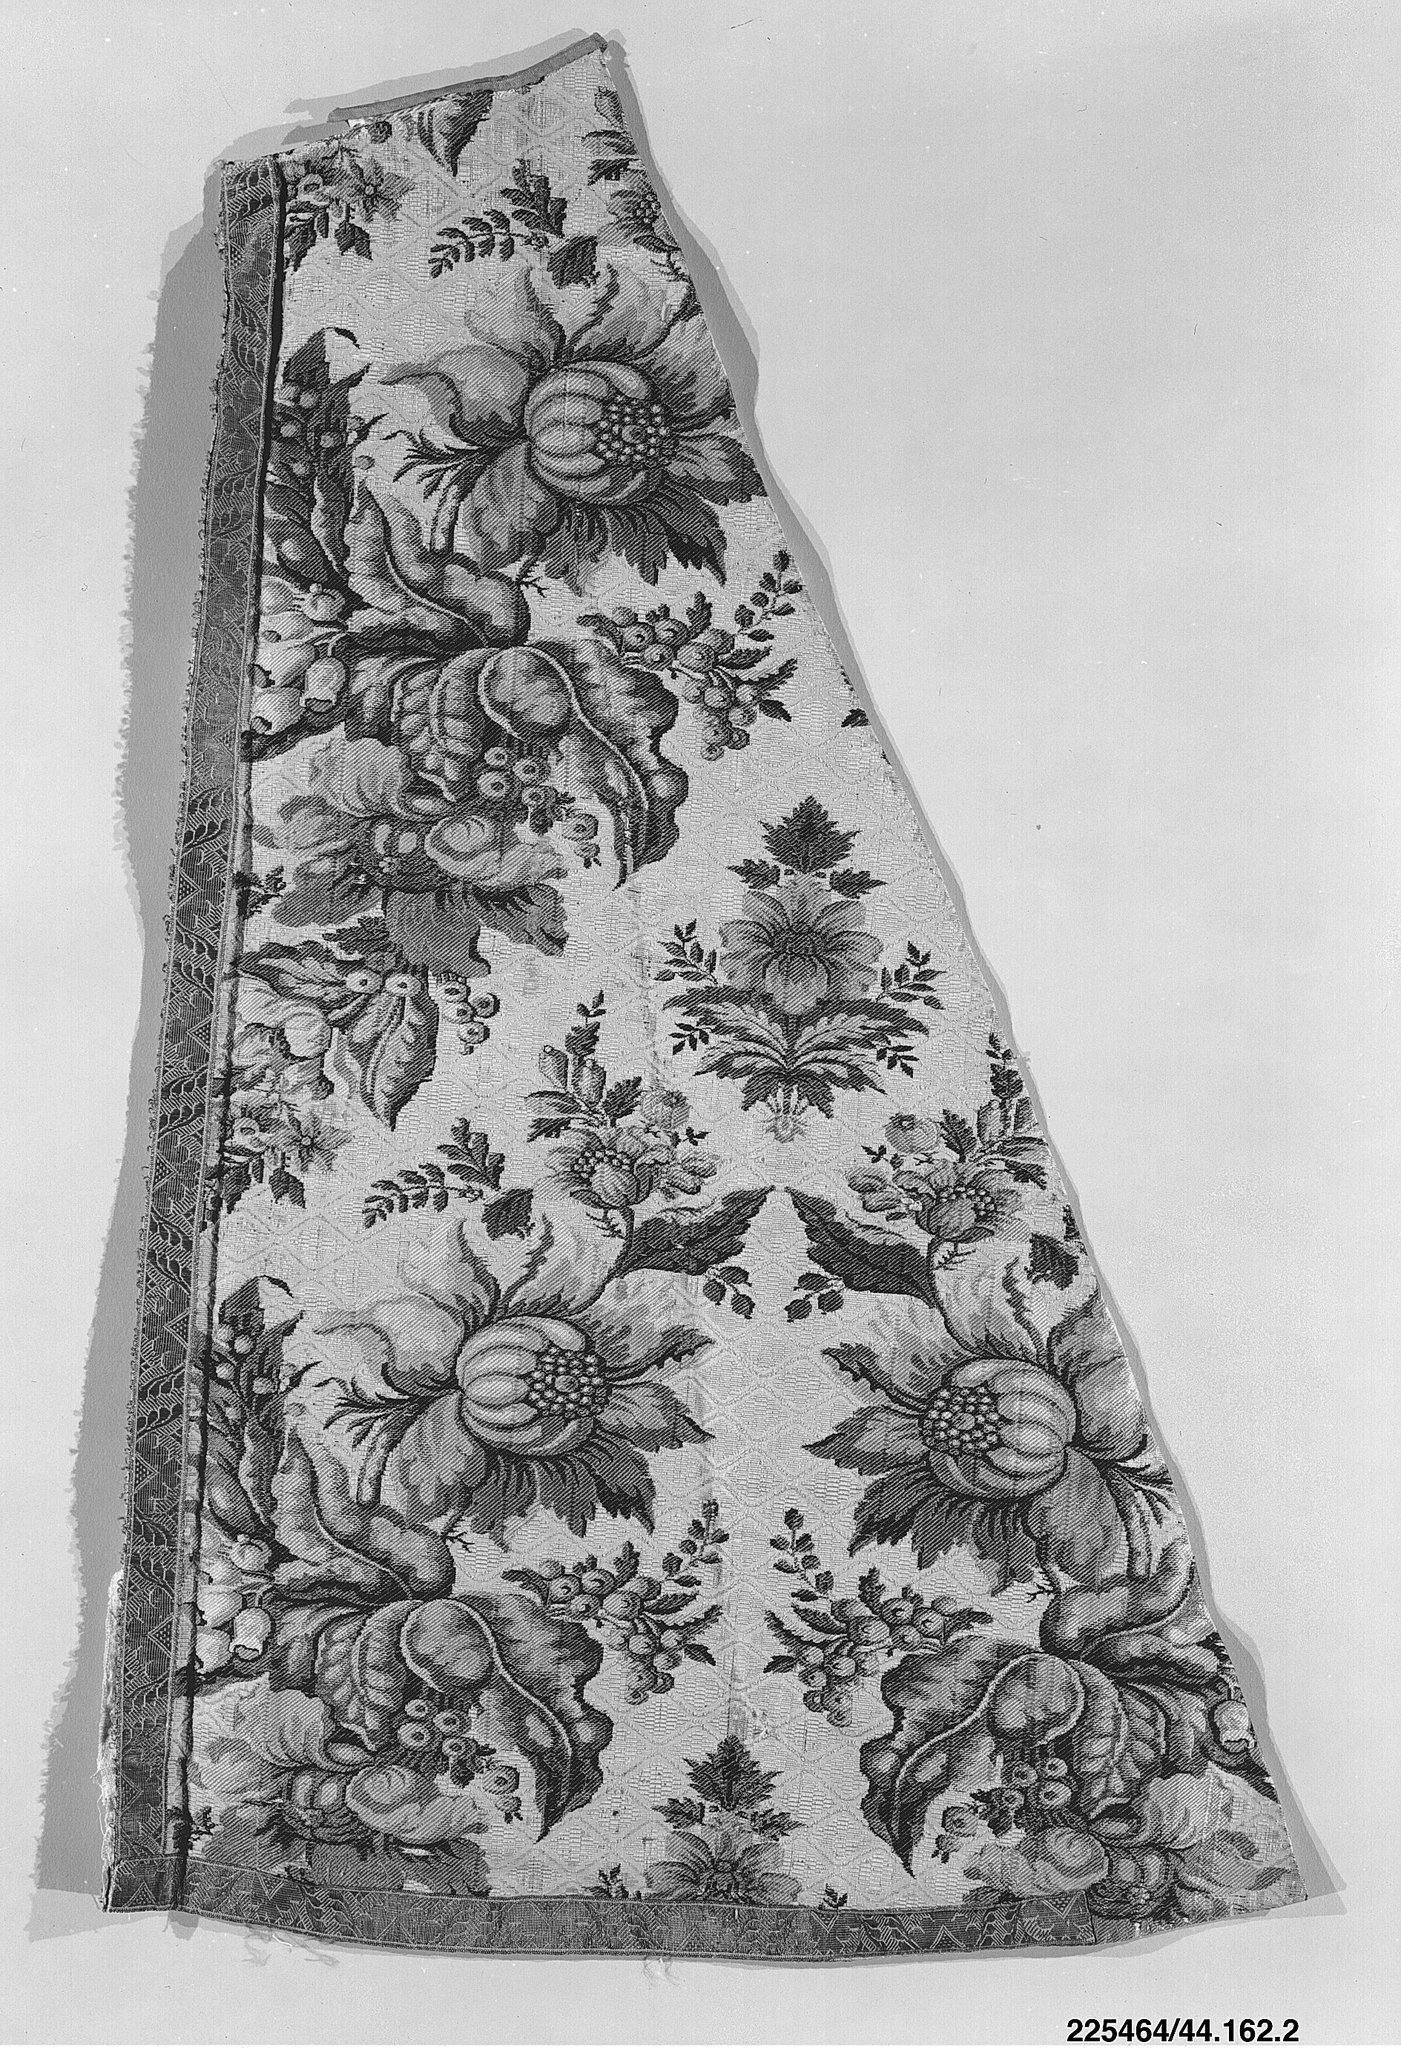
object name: piece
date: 1701-1800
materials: metal thread, silk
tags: flowers,leaves